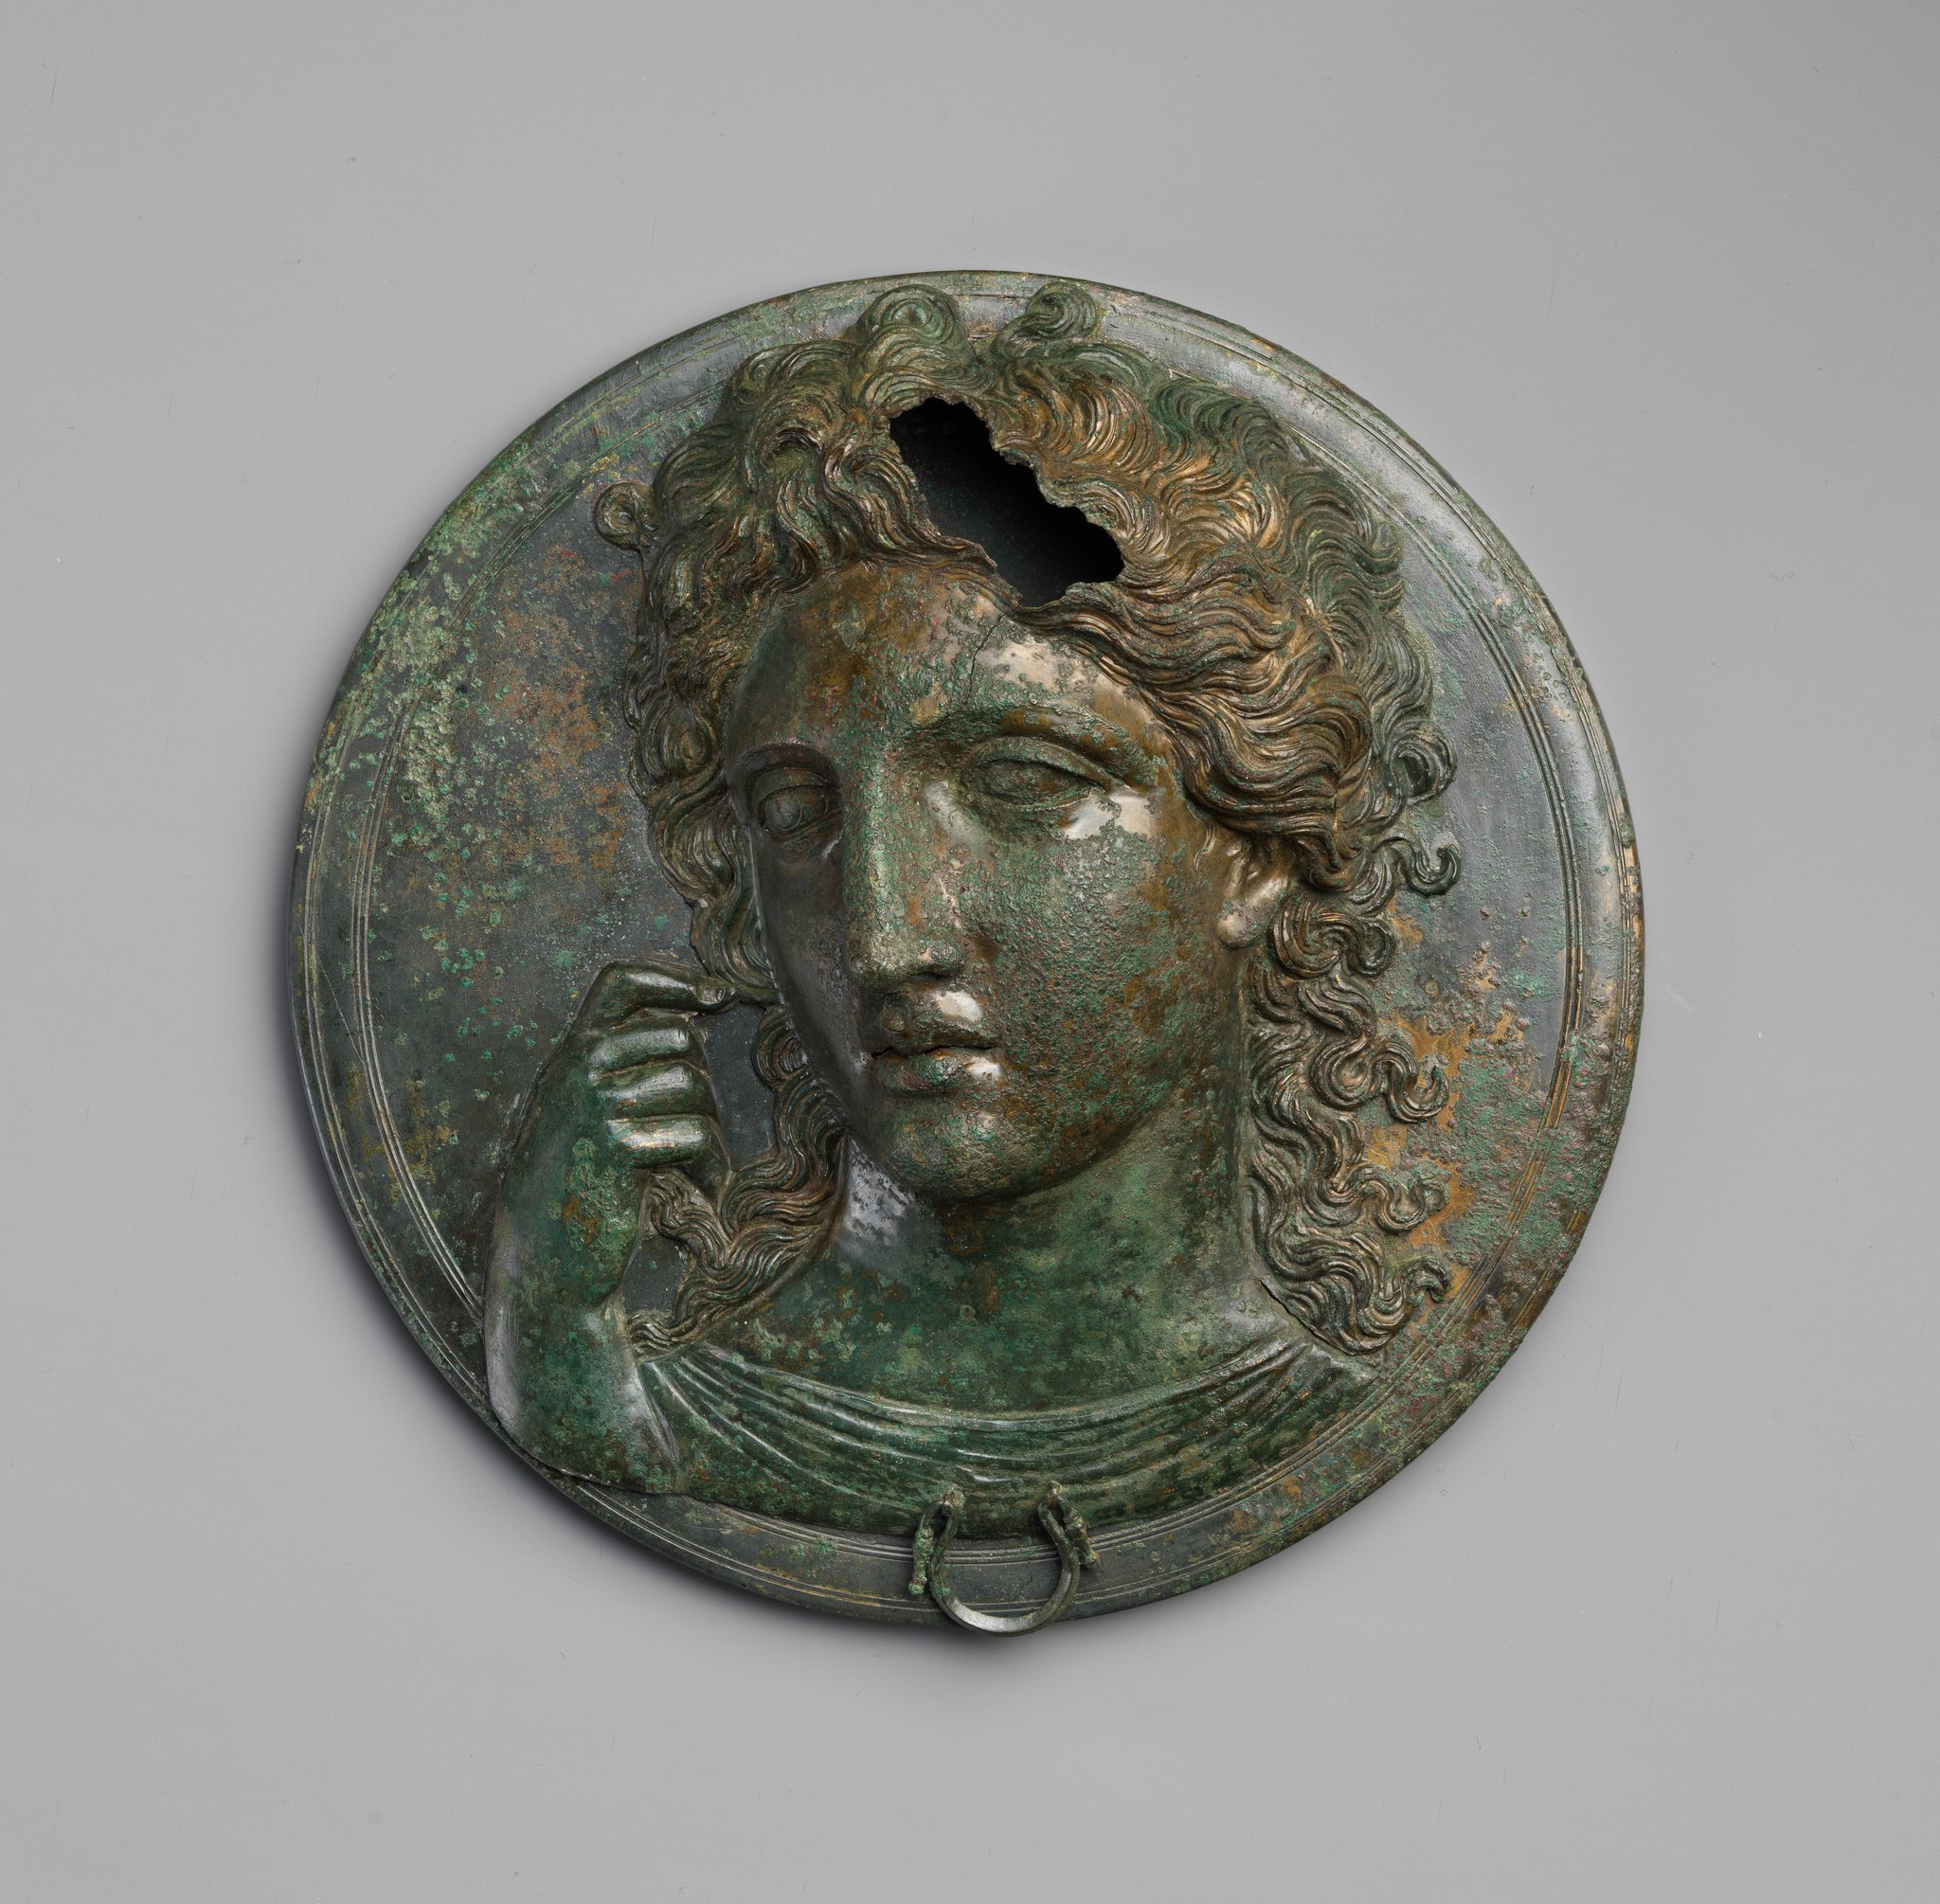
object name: mirror with head of a woman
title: Bronze box mirror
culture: greek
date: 375-351 BCE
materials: bronze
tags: women